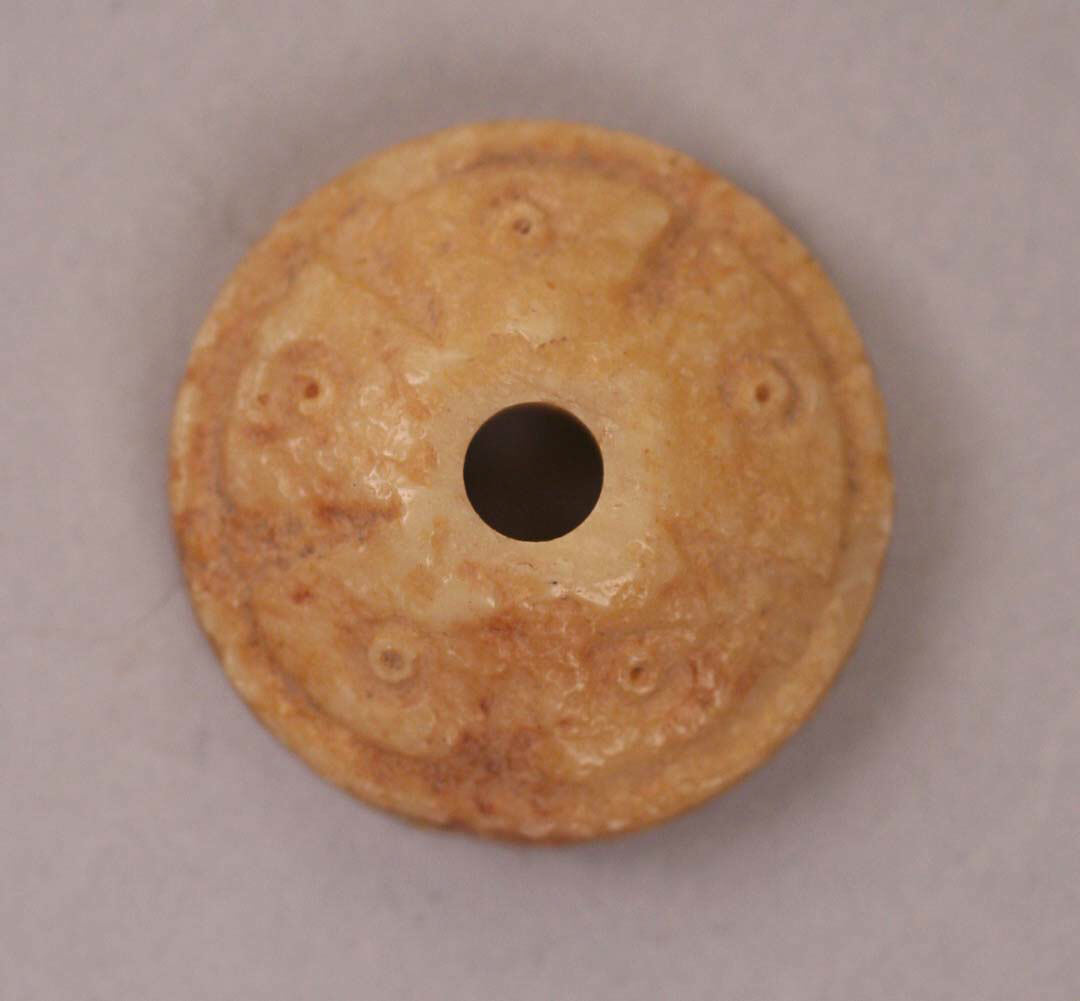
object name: button or bead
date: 801-1000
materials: bone, paint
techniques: incising, inlay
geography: iran